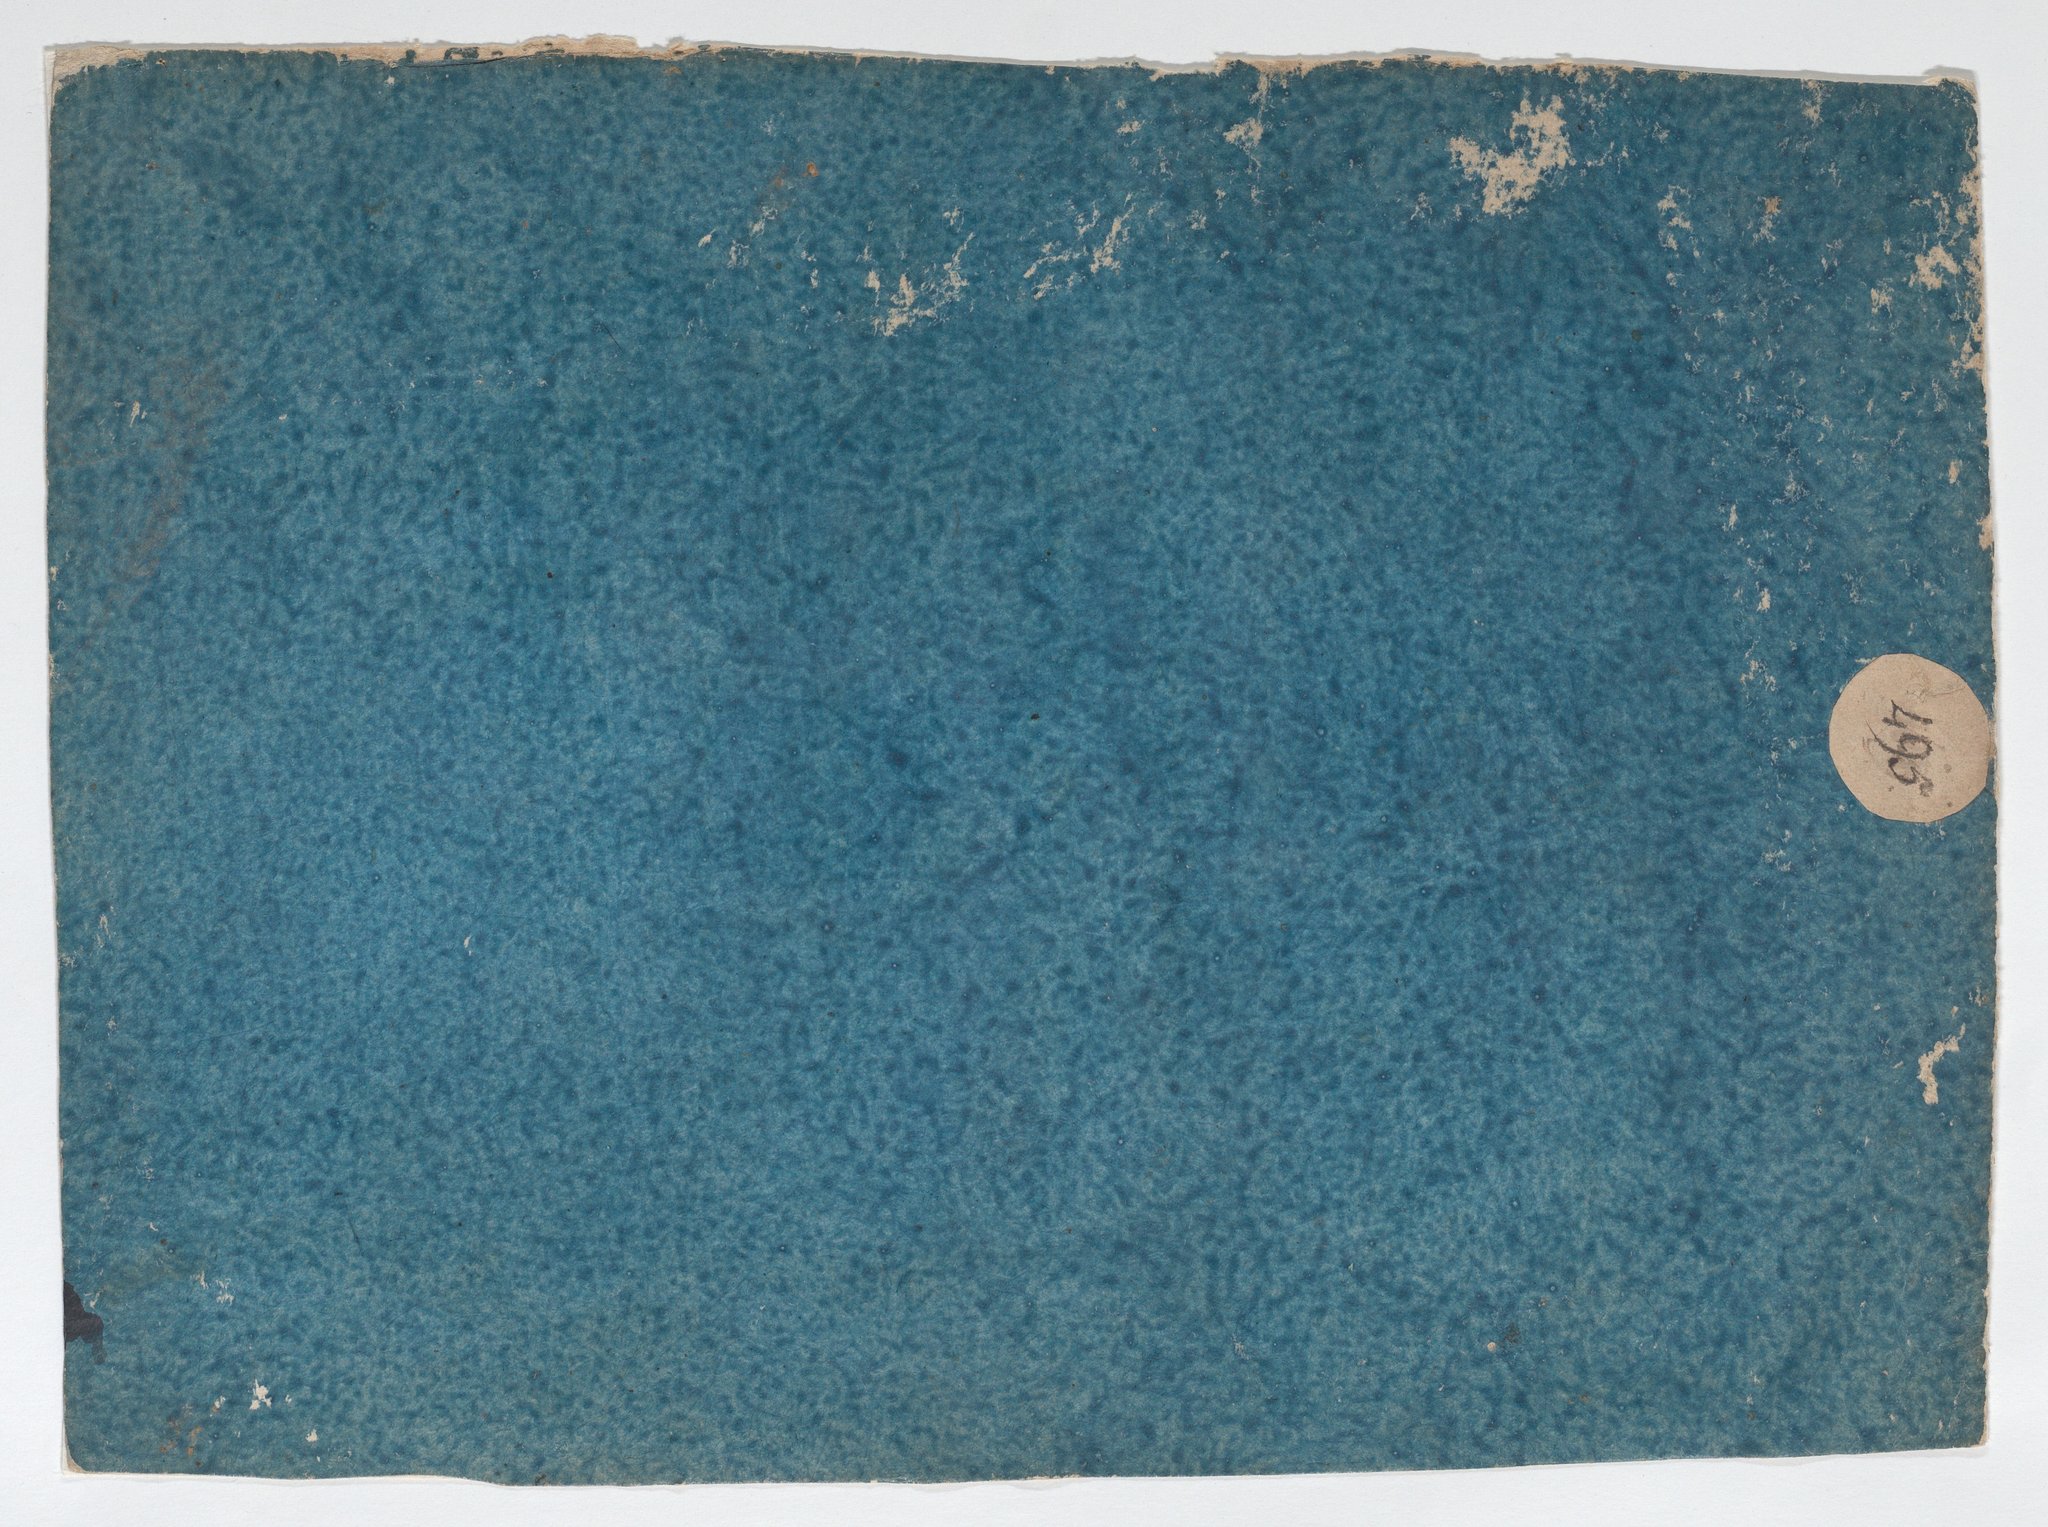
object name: print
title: Blue paste paper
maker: Anonymous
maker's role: artist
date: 1701-1800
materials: paper, paste